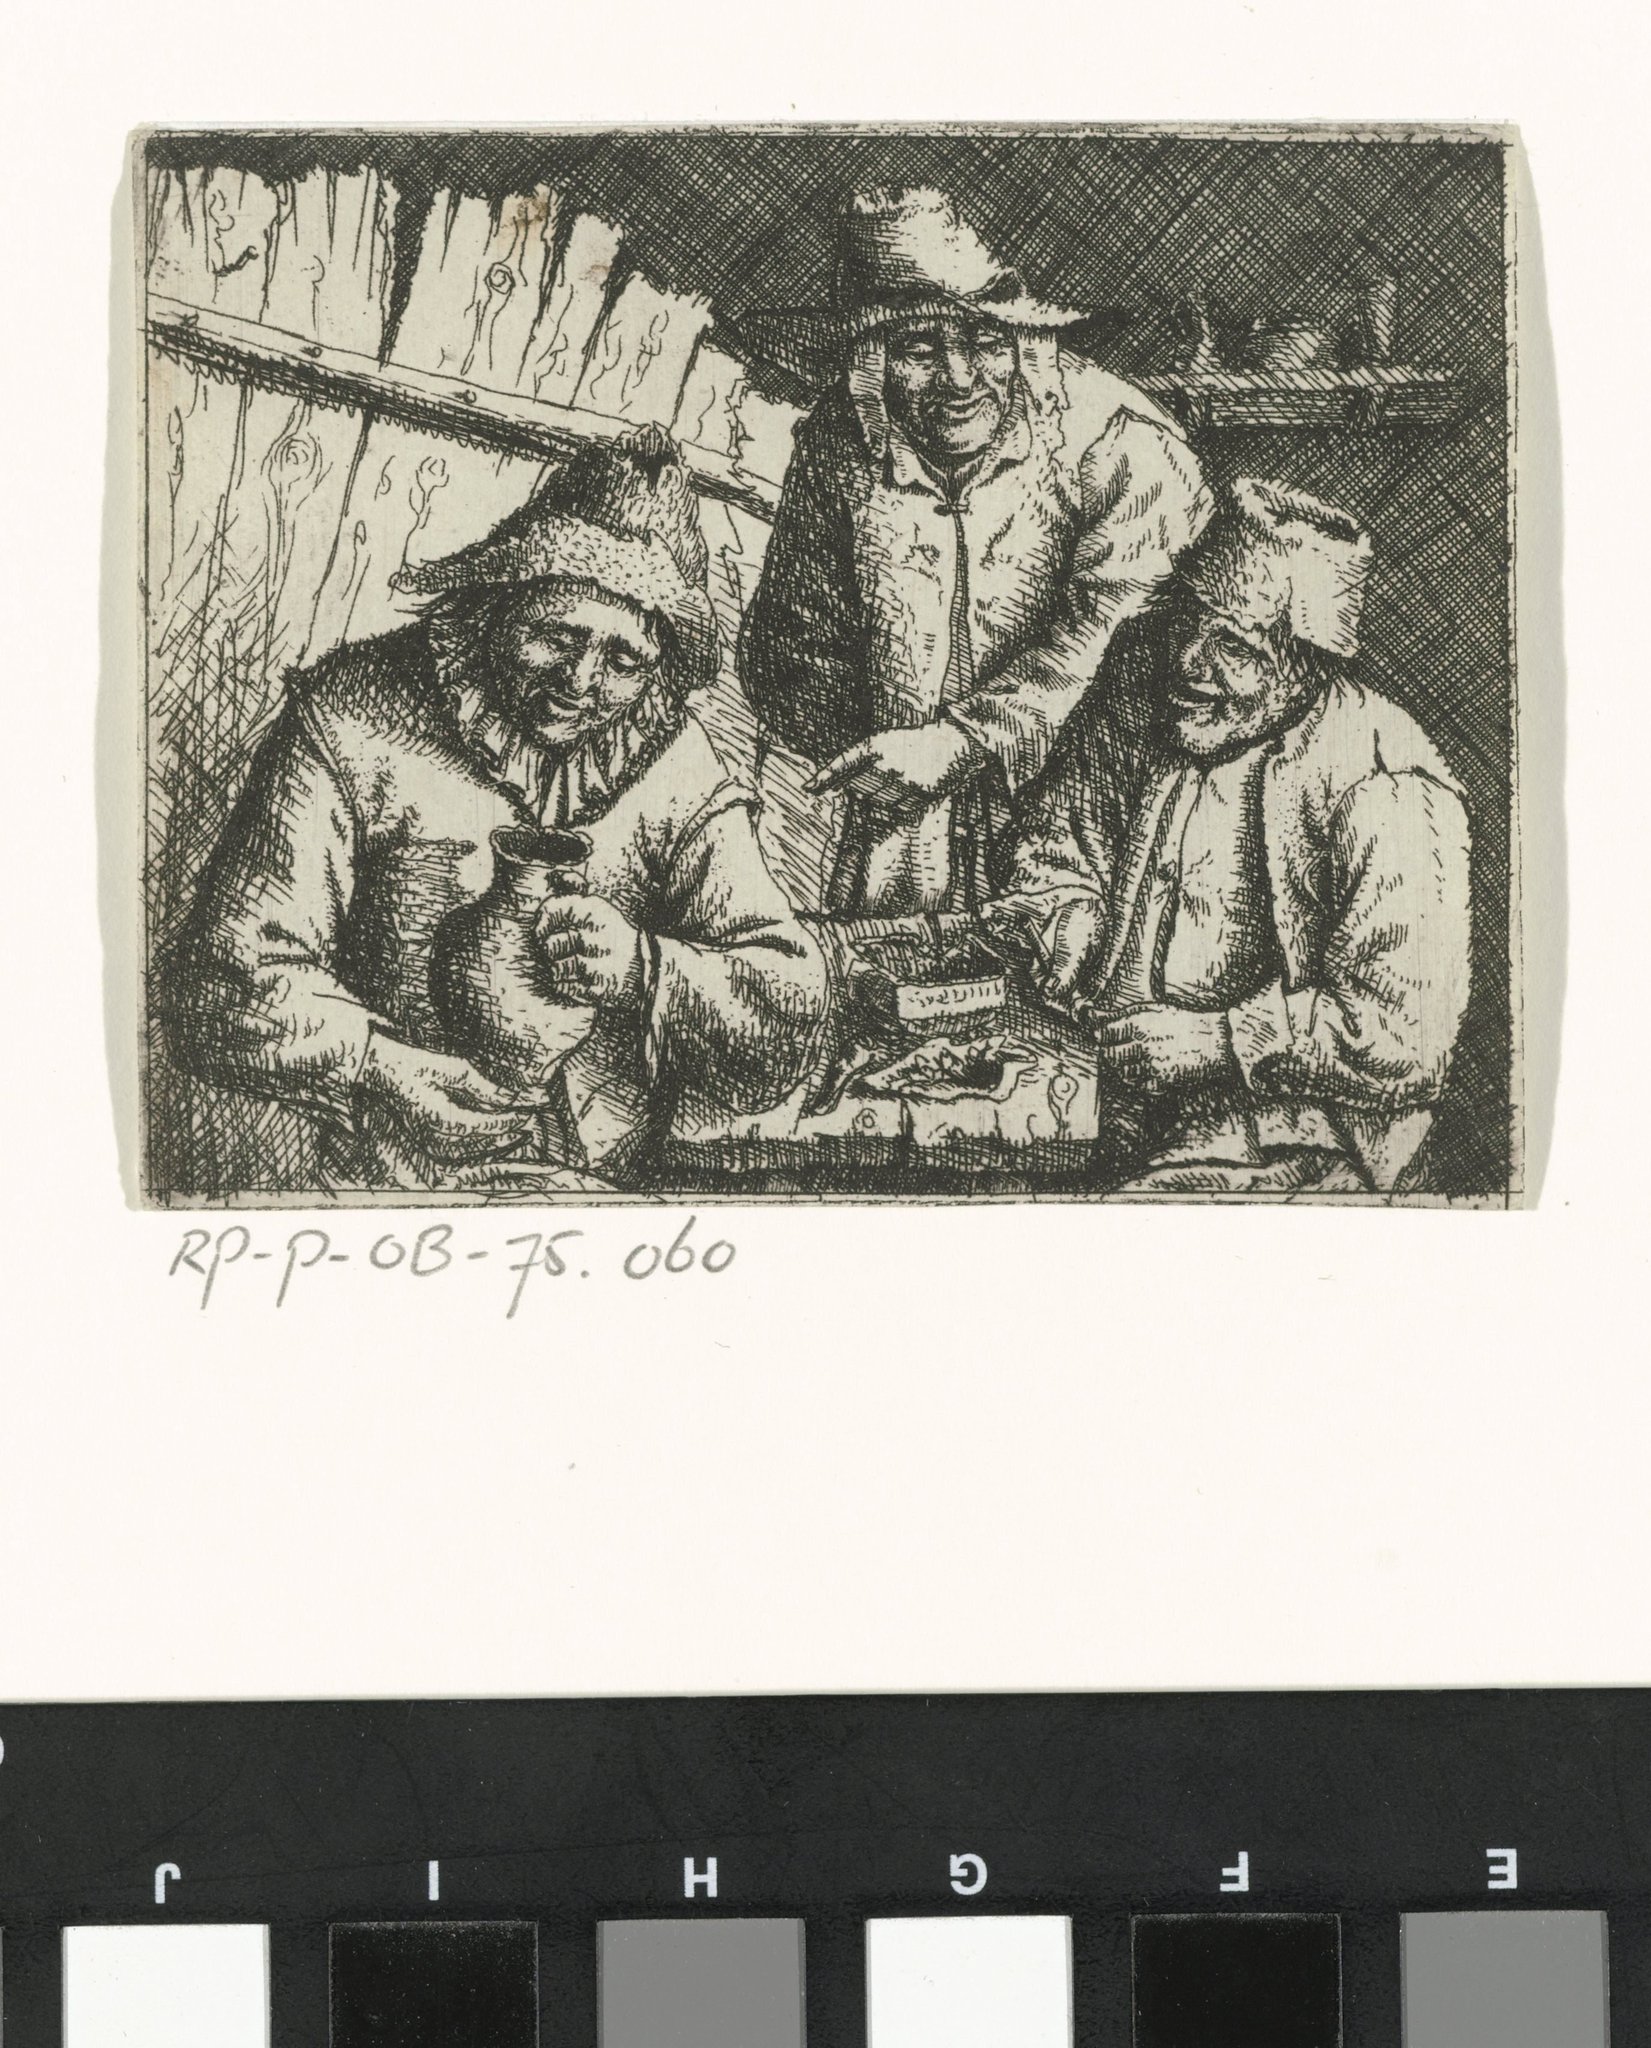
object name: print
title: Drie mannen in een herberg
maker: Anonymous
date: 1650-1800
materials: paper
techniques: etching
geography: netherlands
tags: inn, coffee-house, public house, etc., jar, jug (used as drinking-vessel)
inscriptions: inscription: ‘FM 1884’